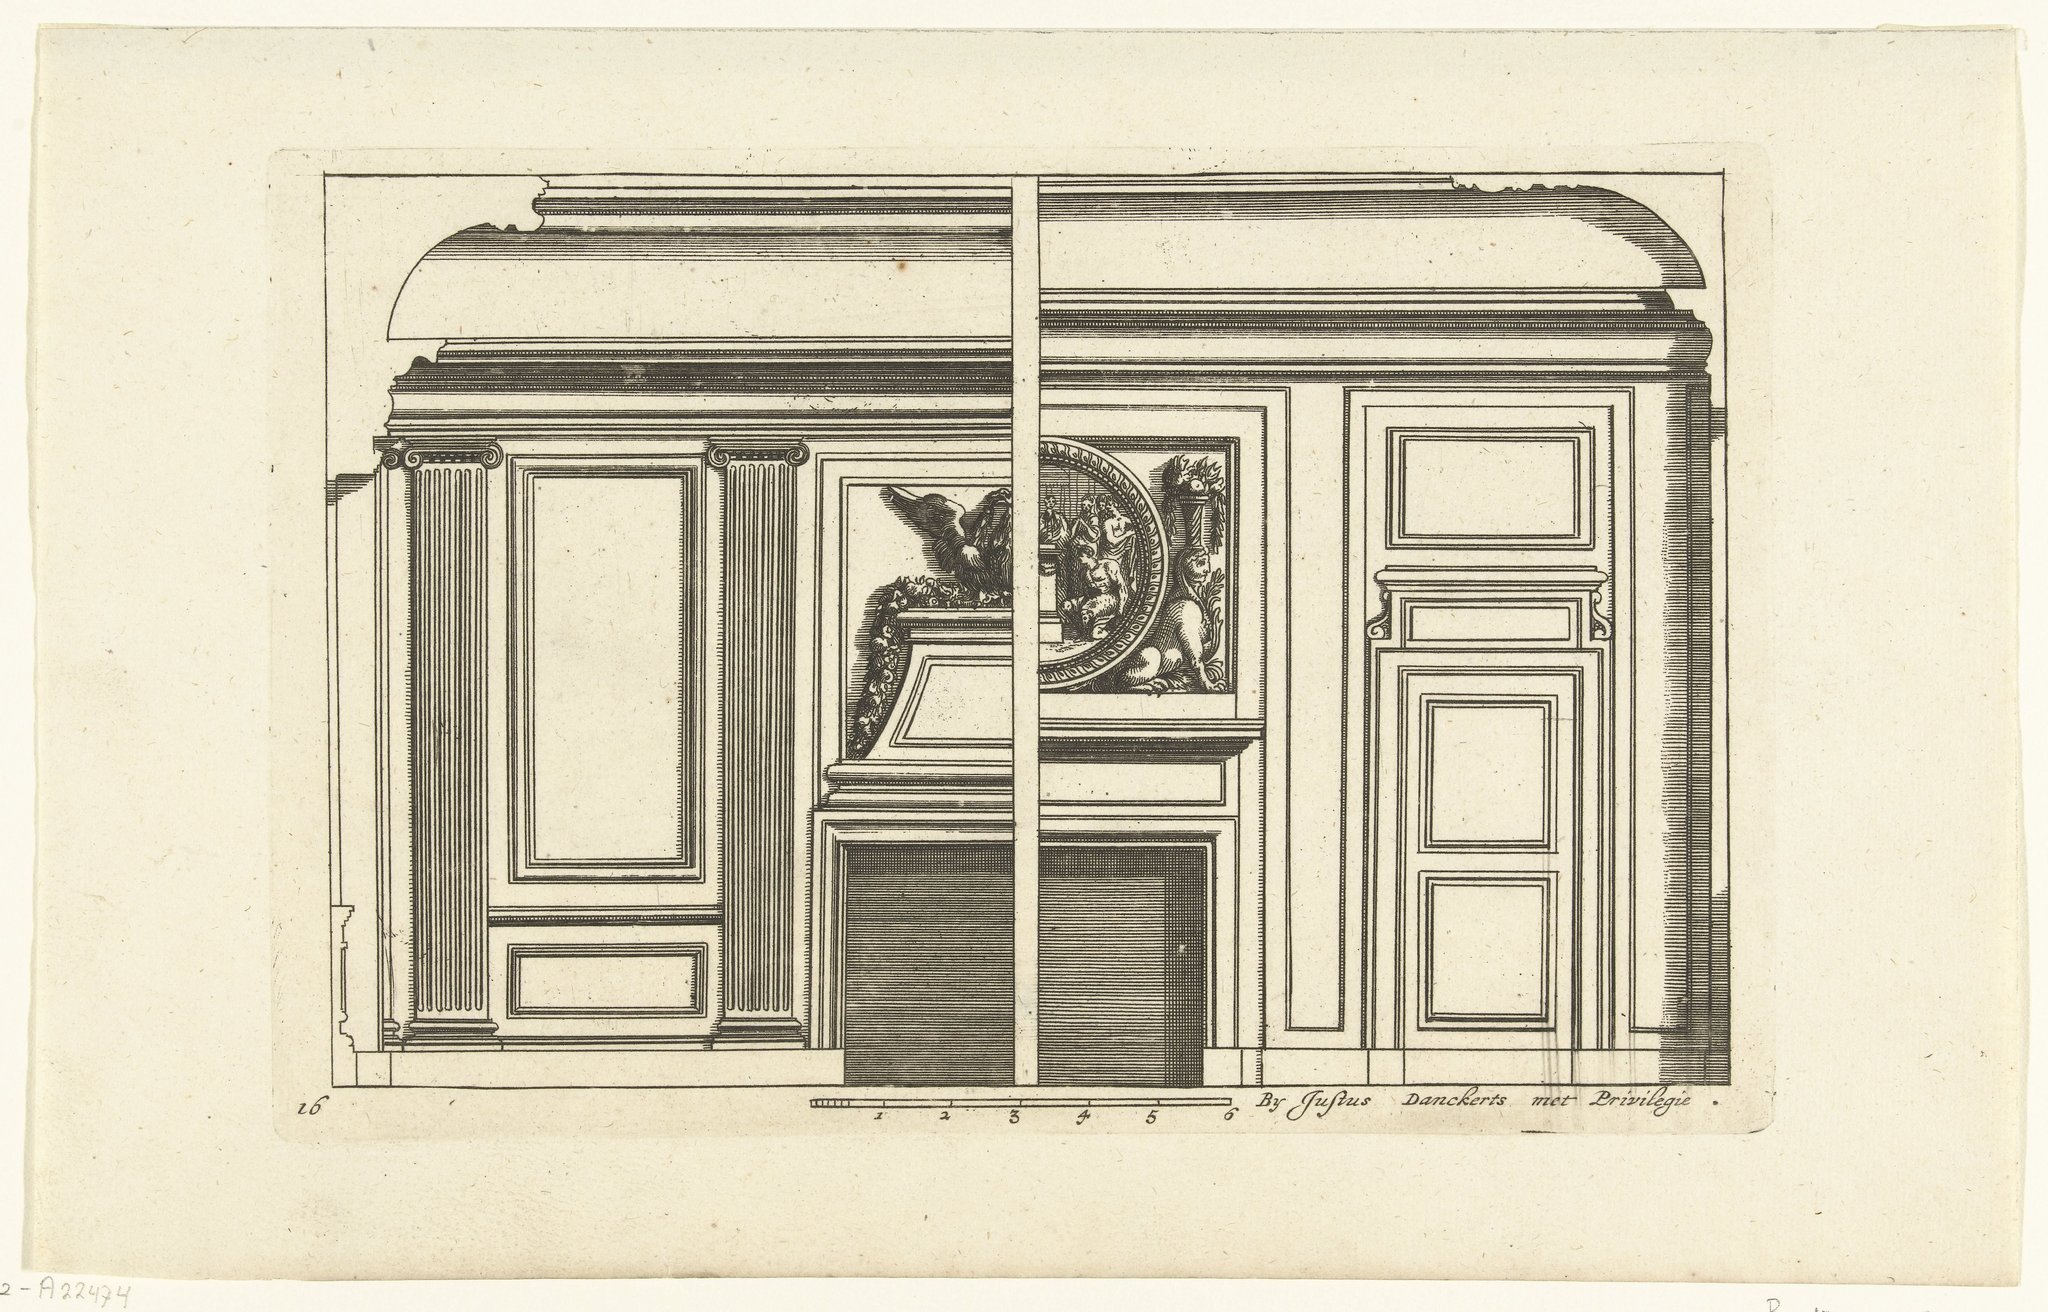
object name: ornament print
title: Muurindeling met onderboezem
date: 1675-1686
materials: paper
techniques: etching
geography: amsterdam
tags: chimney-piece, mantelpiece